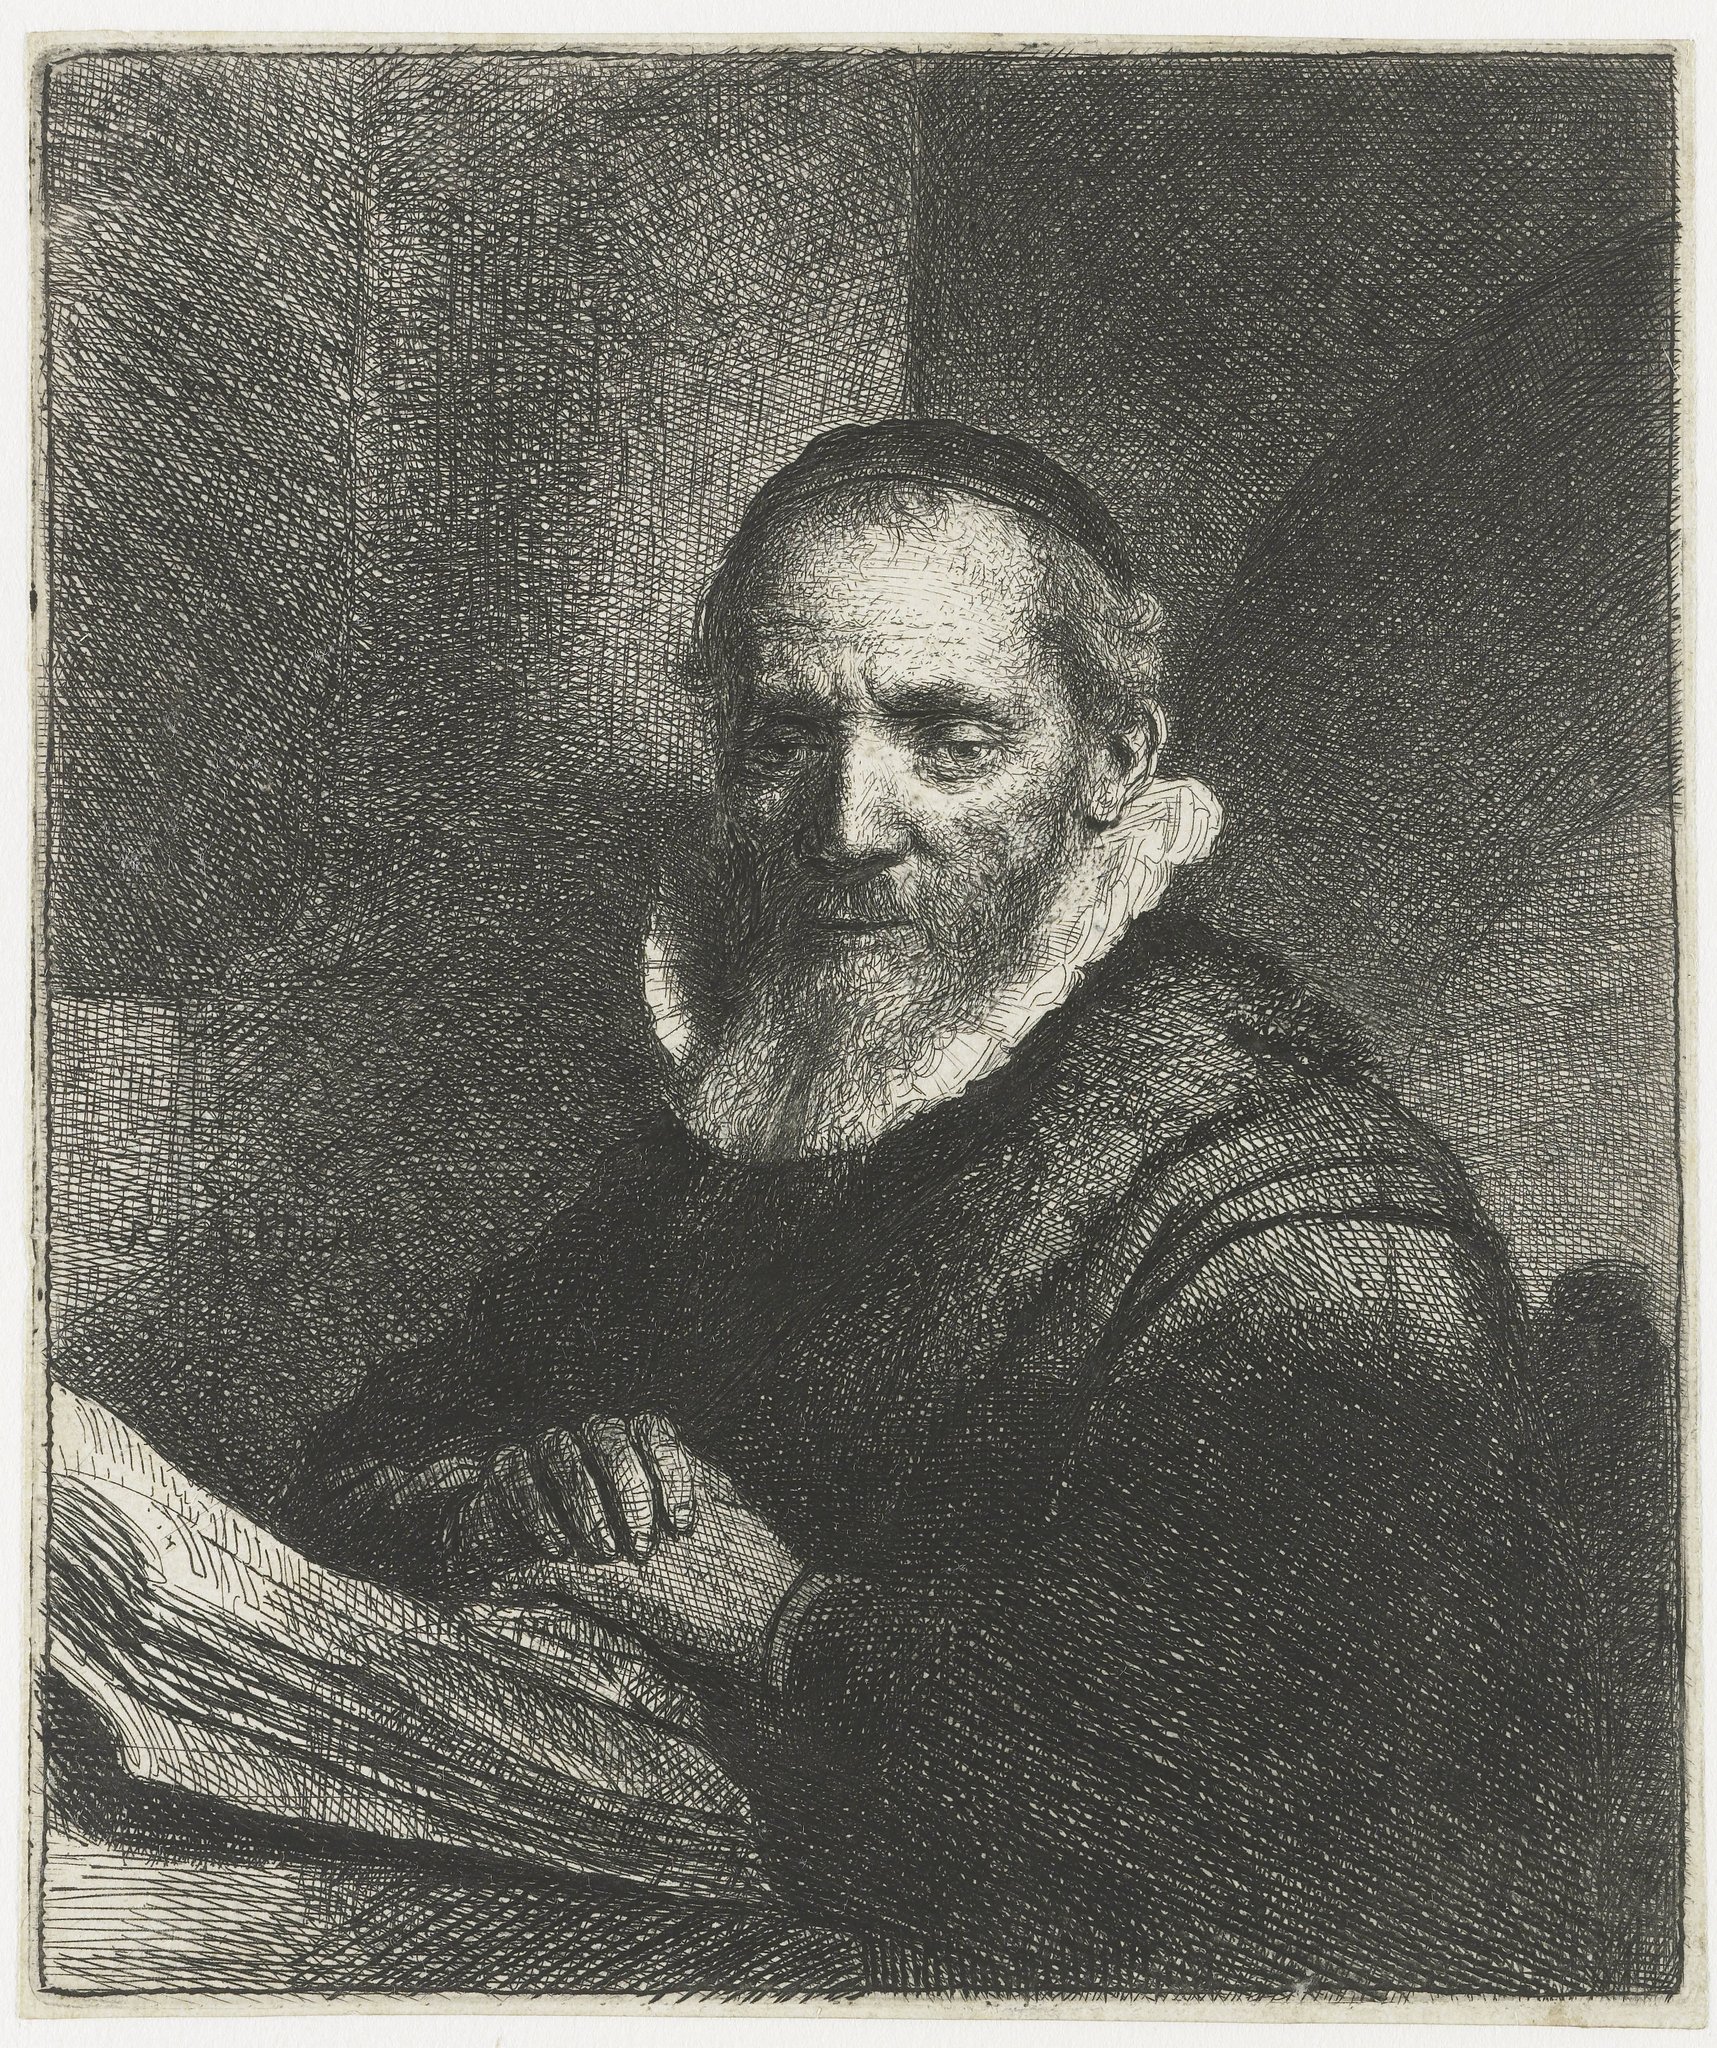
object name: print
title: Jan Cornelis Sylvius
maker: rembrandt van rijn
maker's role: draughtsman, painter, print maker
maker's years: 1606-1669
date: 1633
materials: paper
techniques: etching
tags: amsterdam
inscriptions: signature and date: ‘Rembrandt f 1633’, collector's mark: Lugt 2228, collector's mark: ‘G (a sec)’ Lugt 1120, mark: ‘fc (in een cirkel)’